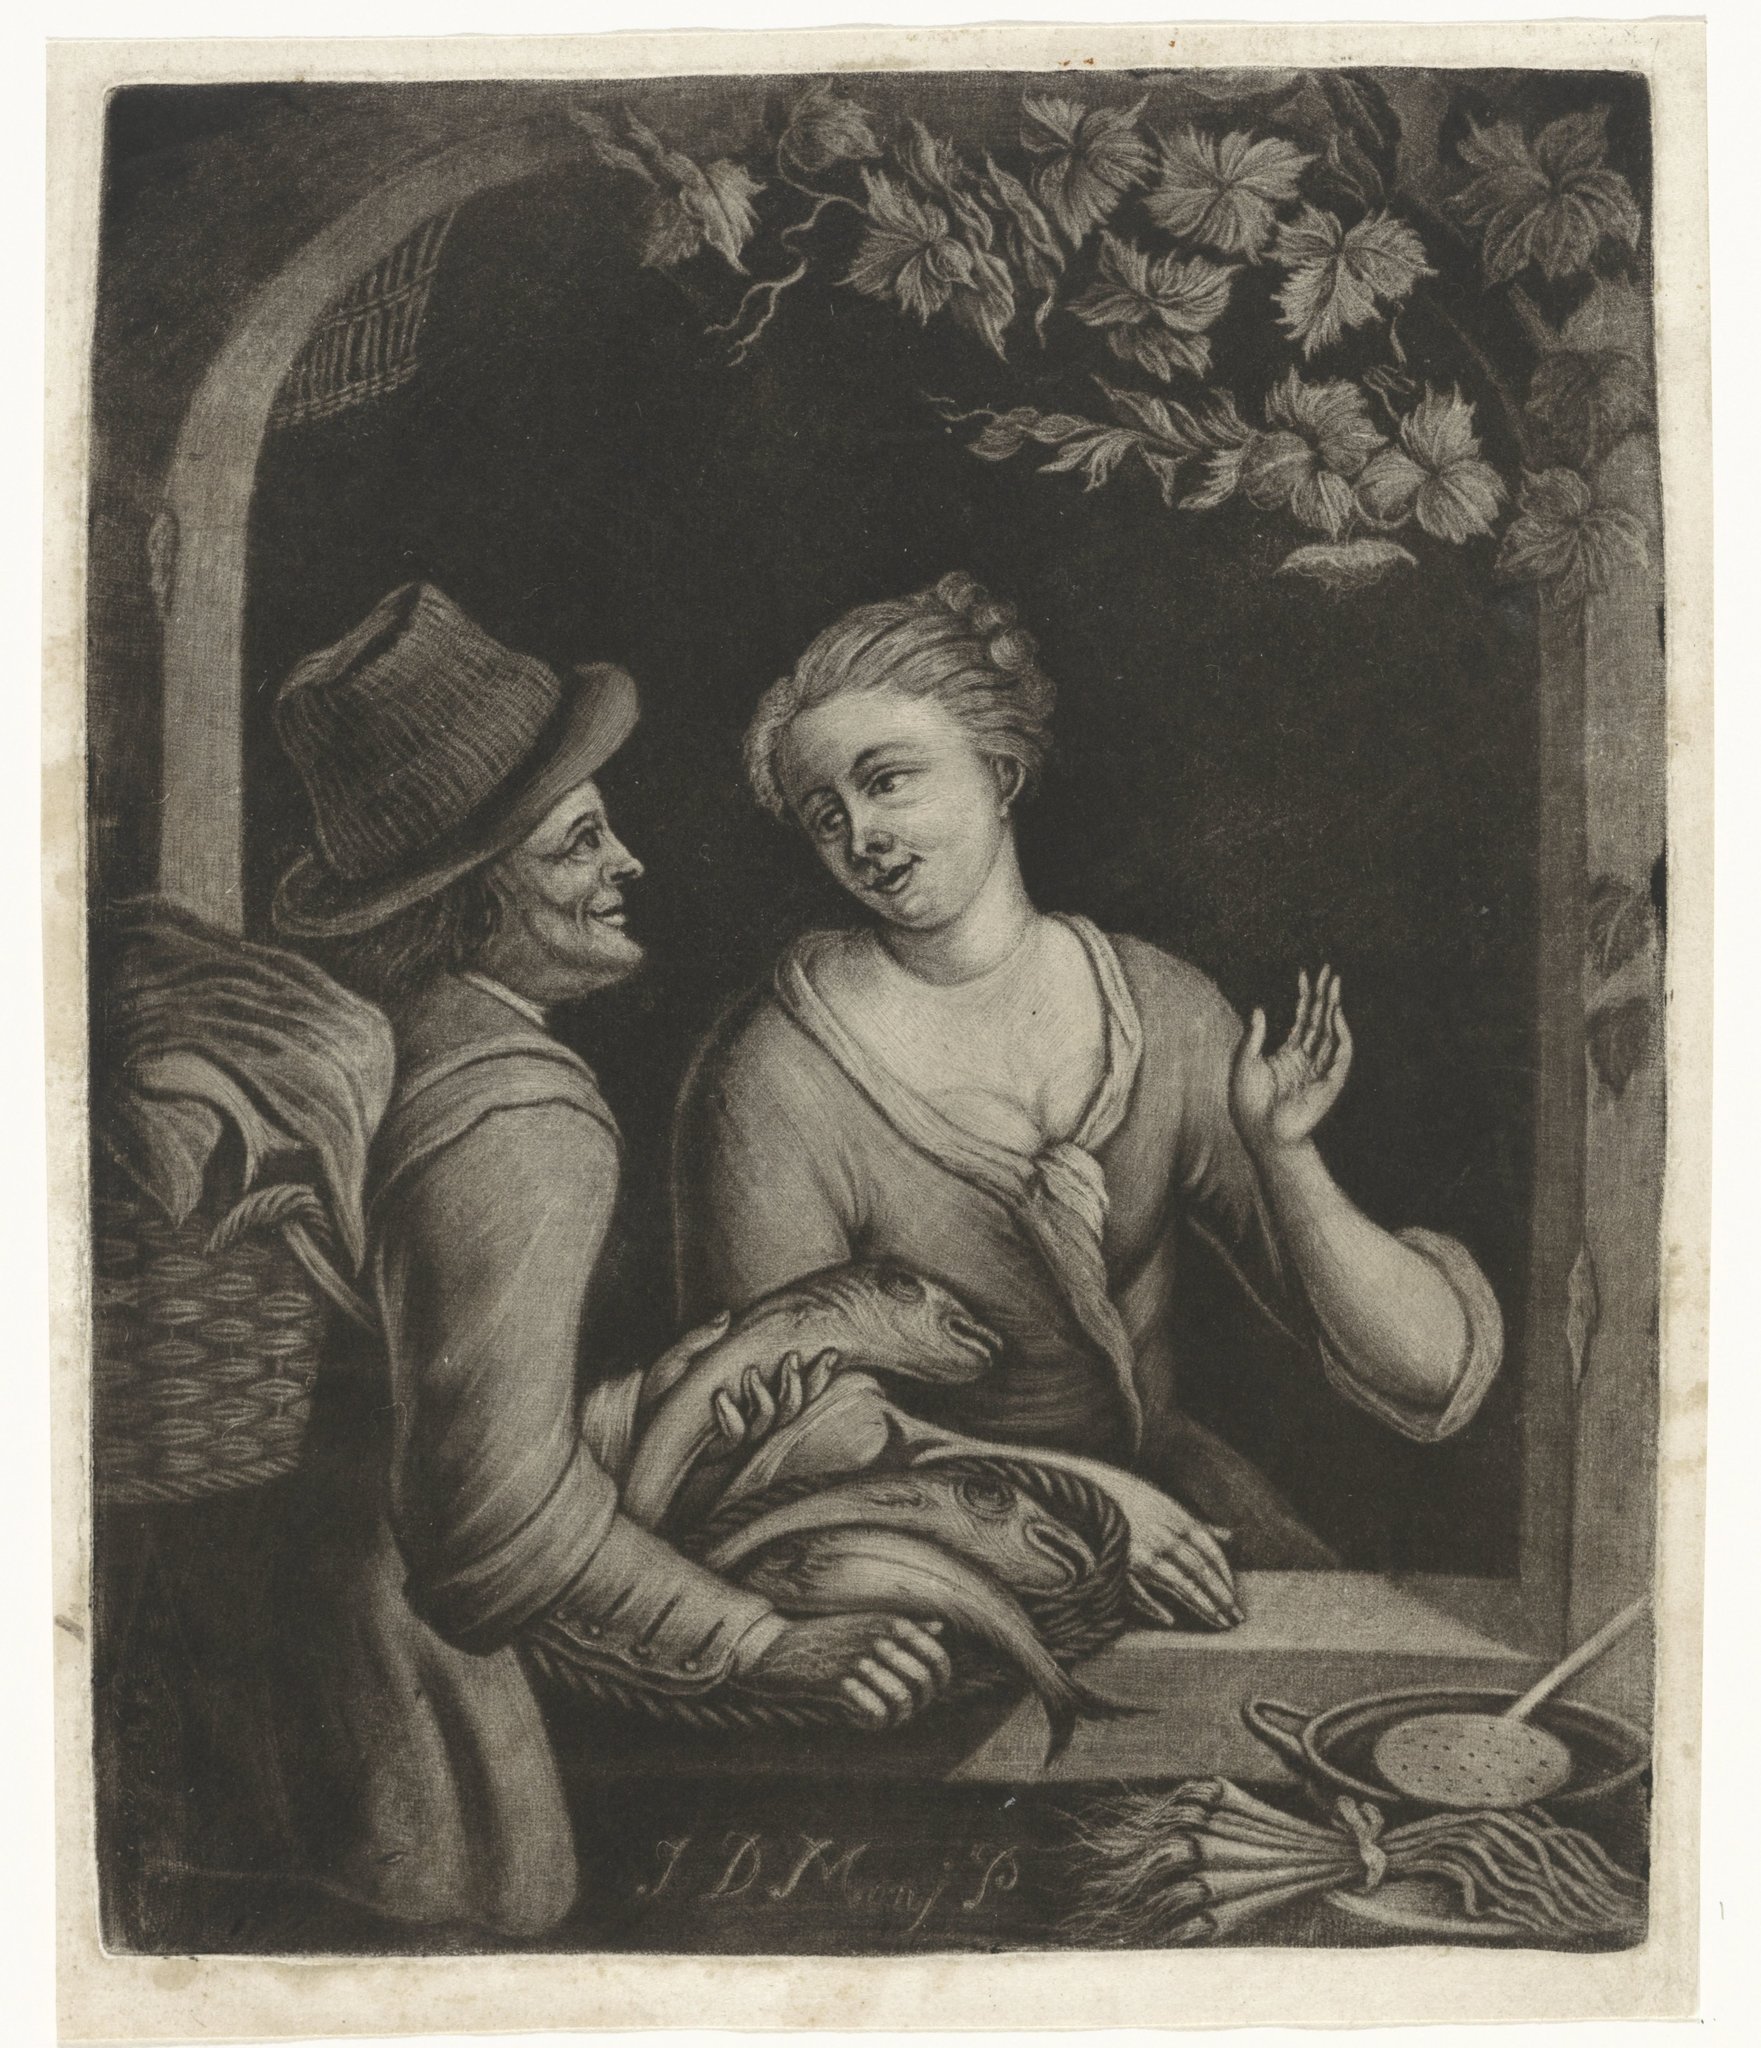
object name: print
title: Visverkoper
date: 1723-1789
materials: paper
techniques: mezzotint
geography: dordrecht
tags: vine, fishes, merchant, salesman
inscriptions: collector's mark: Lugt 2228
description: Een visboer, met een met vis gevulde mand op de rug, biedt een vrouw vis aan. Zij staat achter een open venster waar een wingerd tegenop groeit.